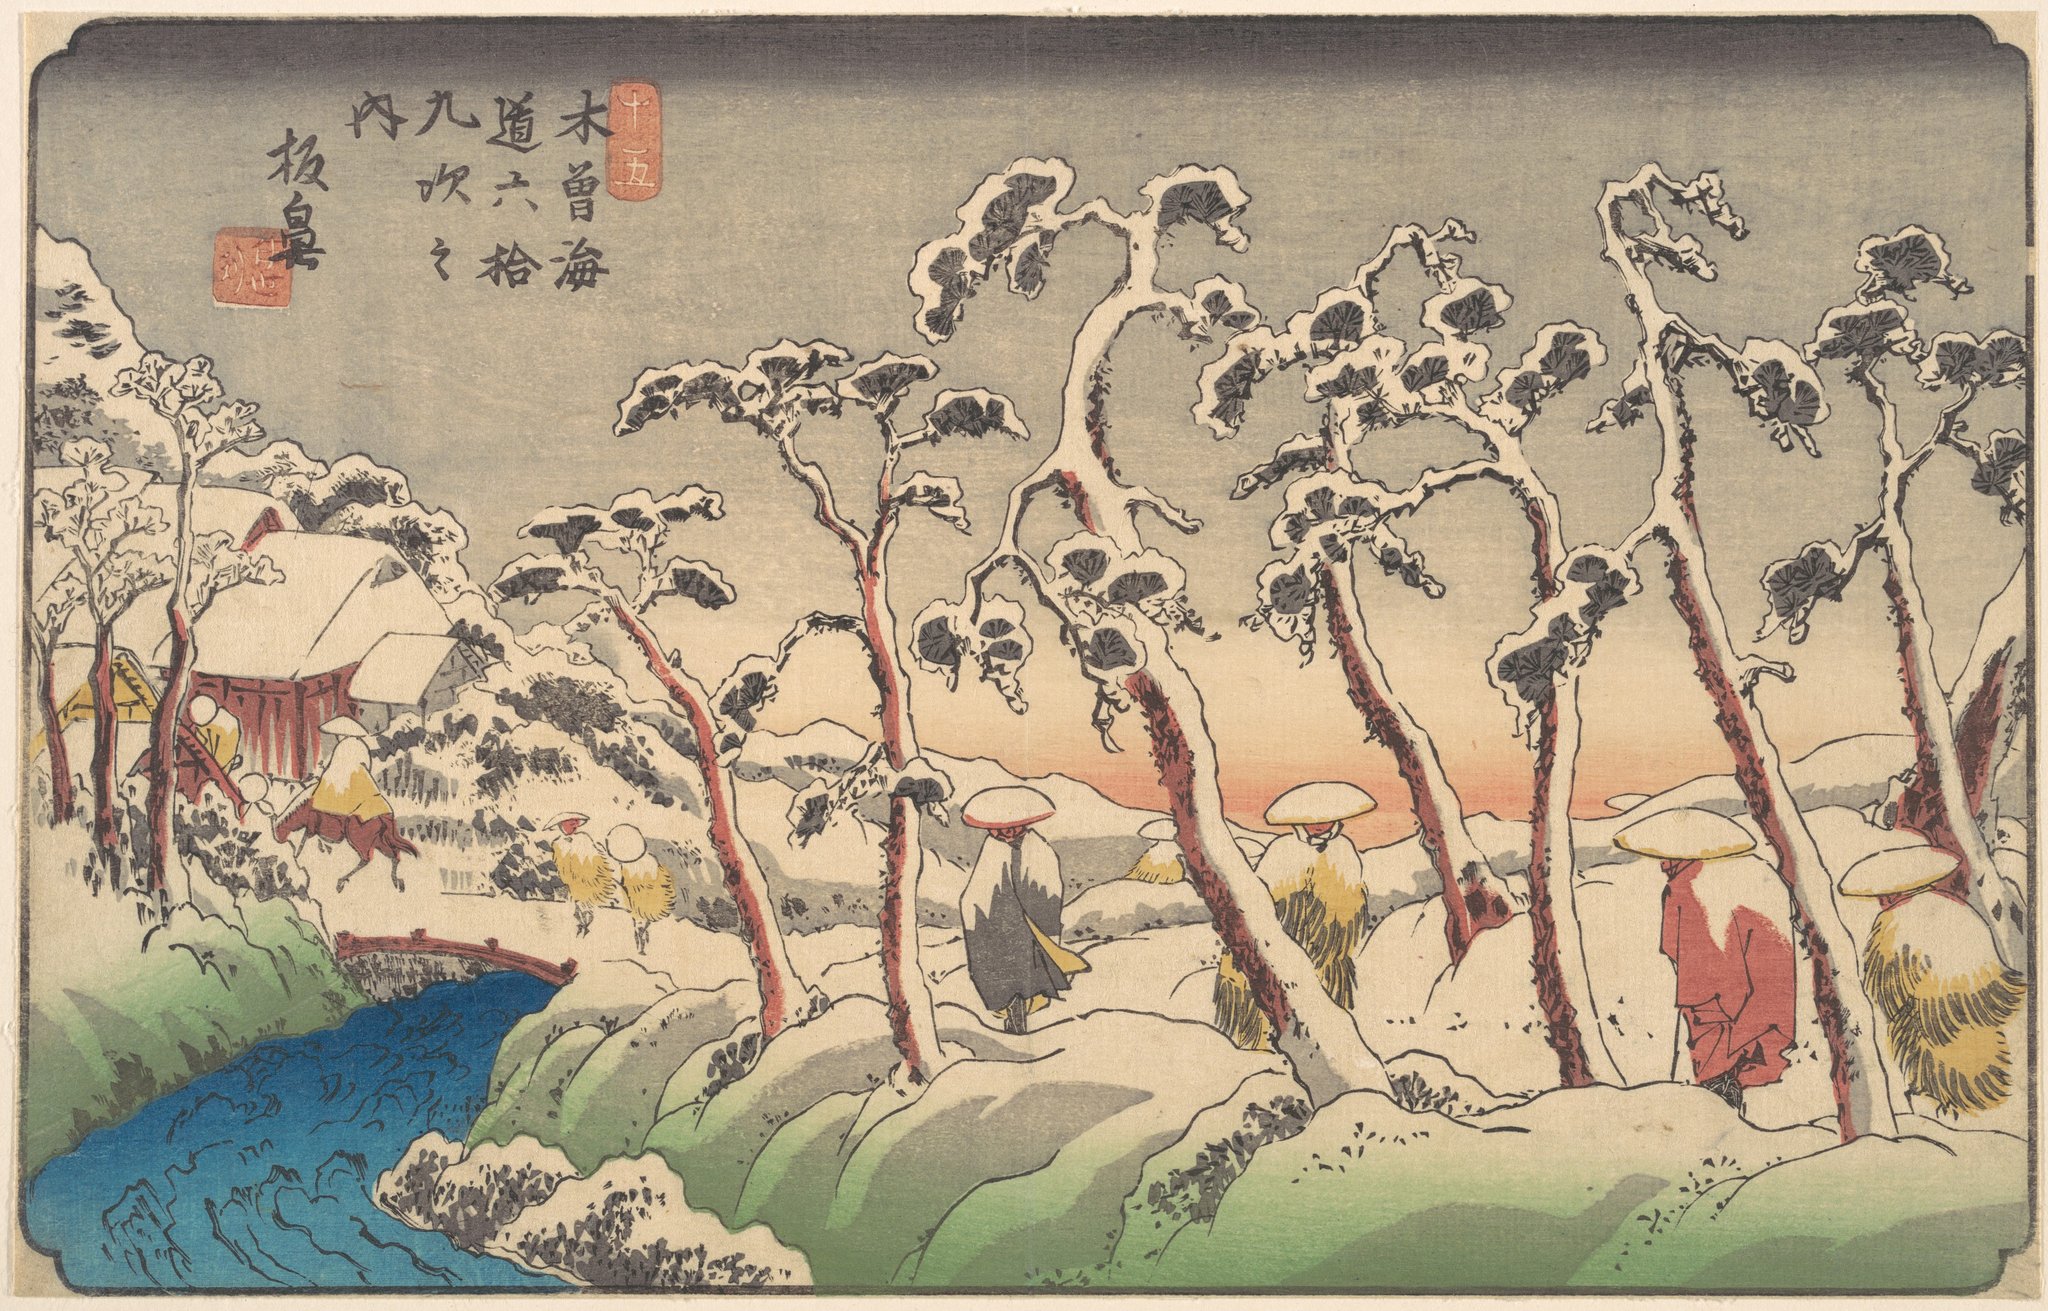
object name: print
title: Itabana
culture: japanese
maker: keisai eisen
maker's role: artist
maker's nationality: japanese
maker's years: 1790-1848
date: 1790-1848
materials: ink, paper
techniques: woodblock print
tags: human figures,trees,snow,streams